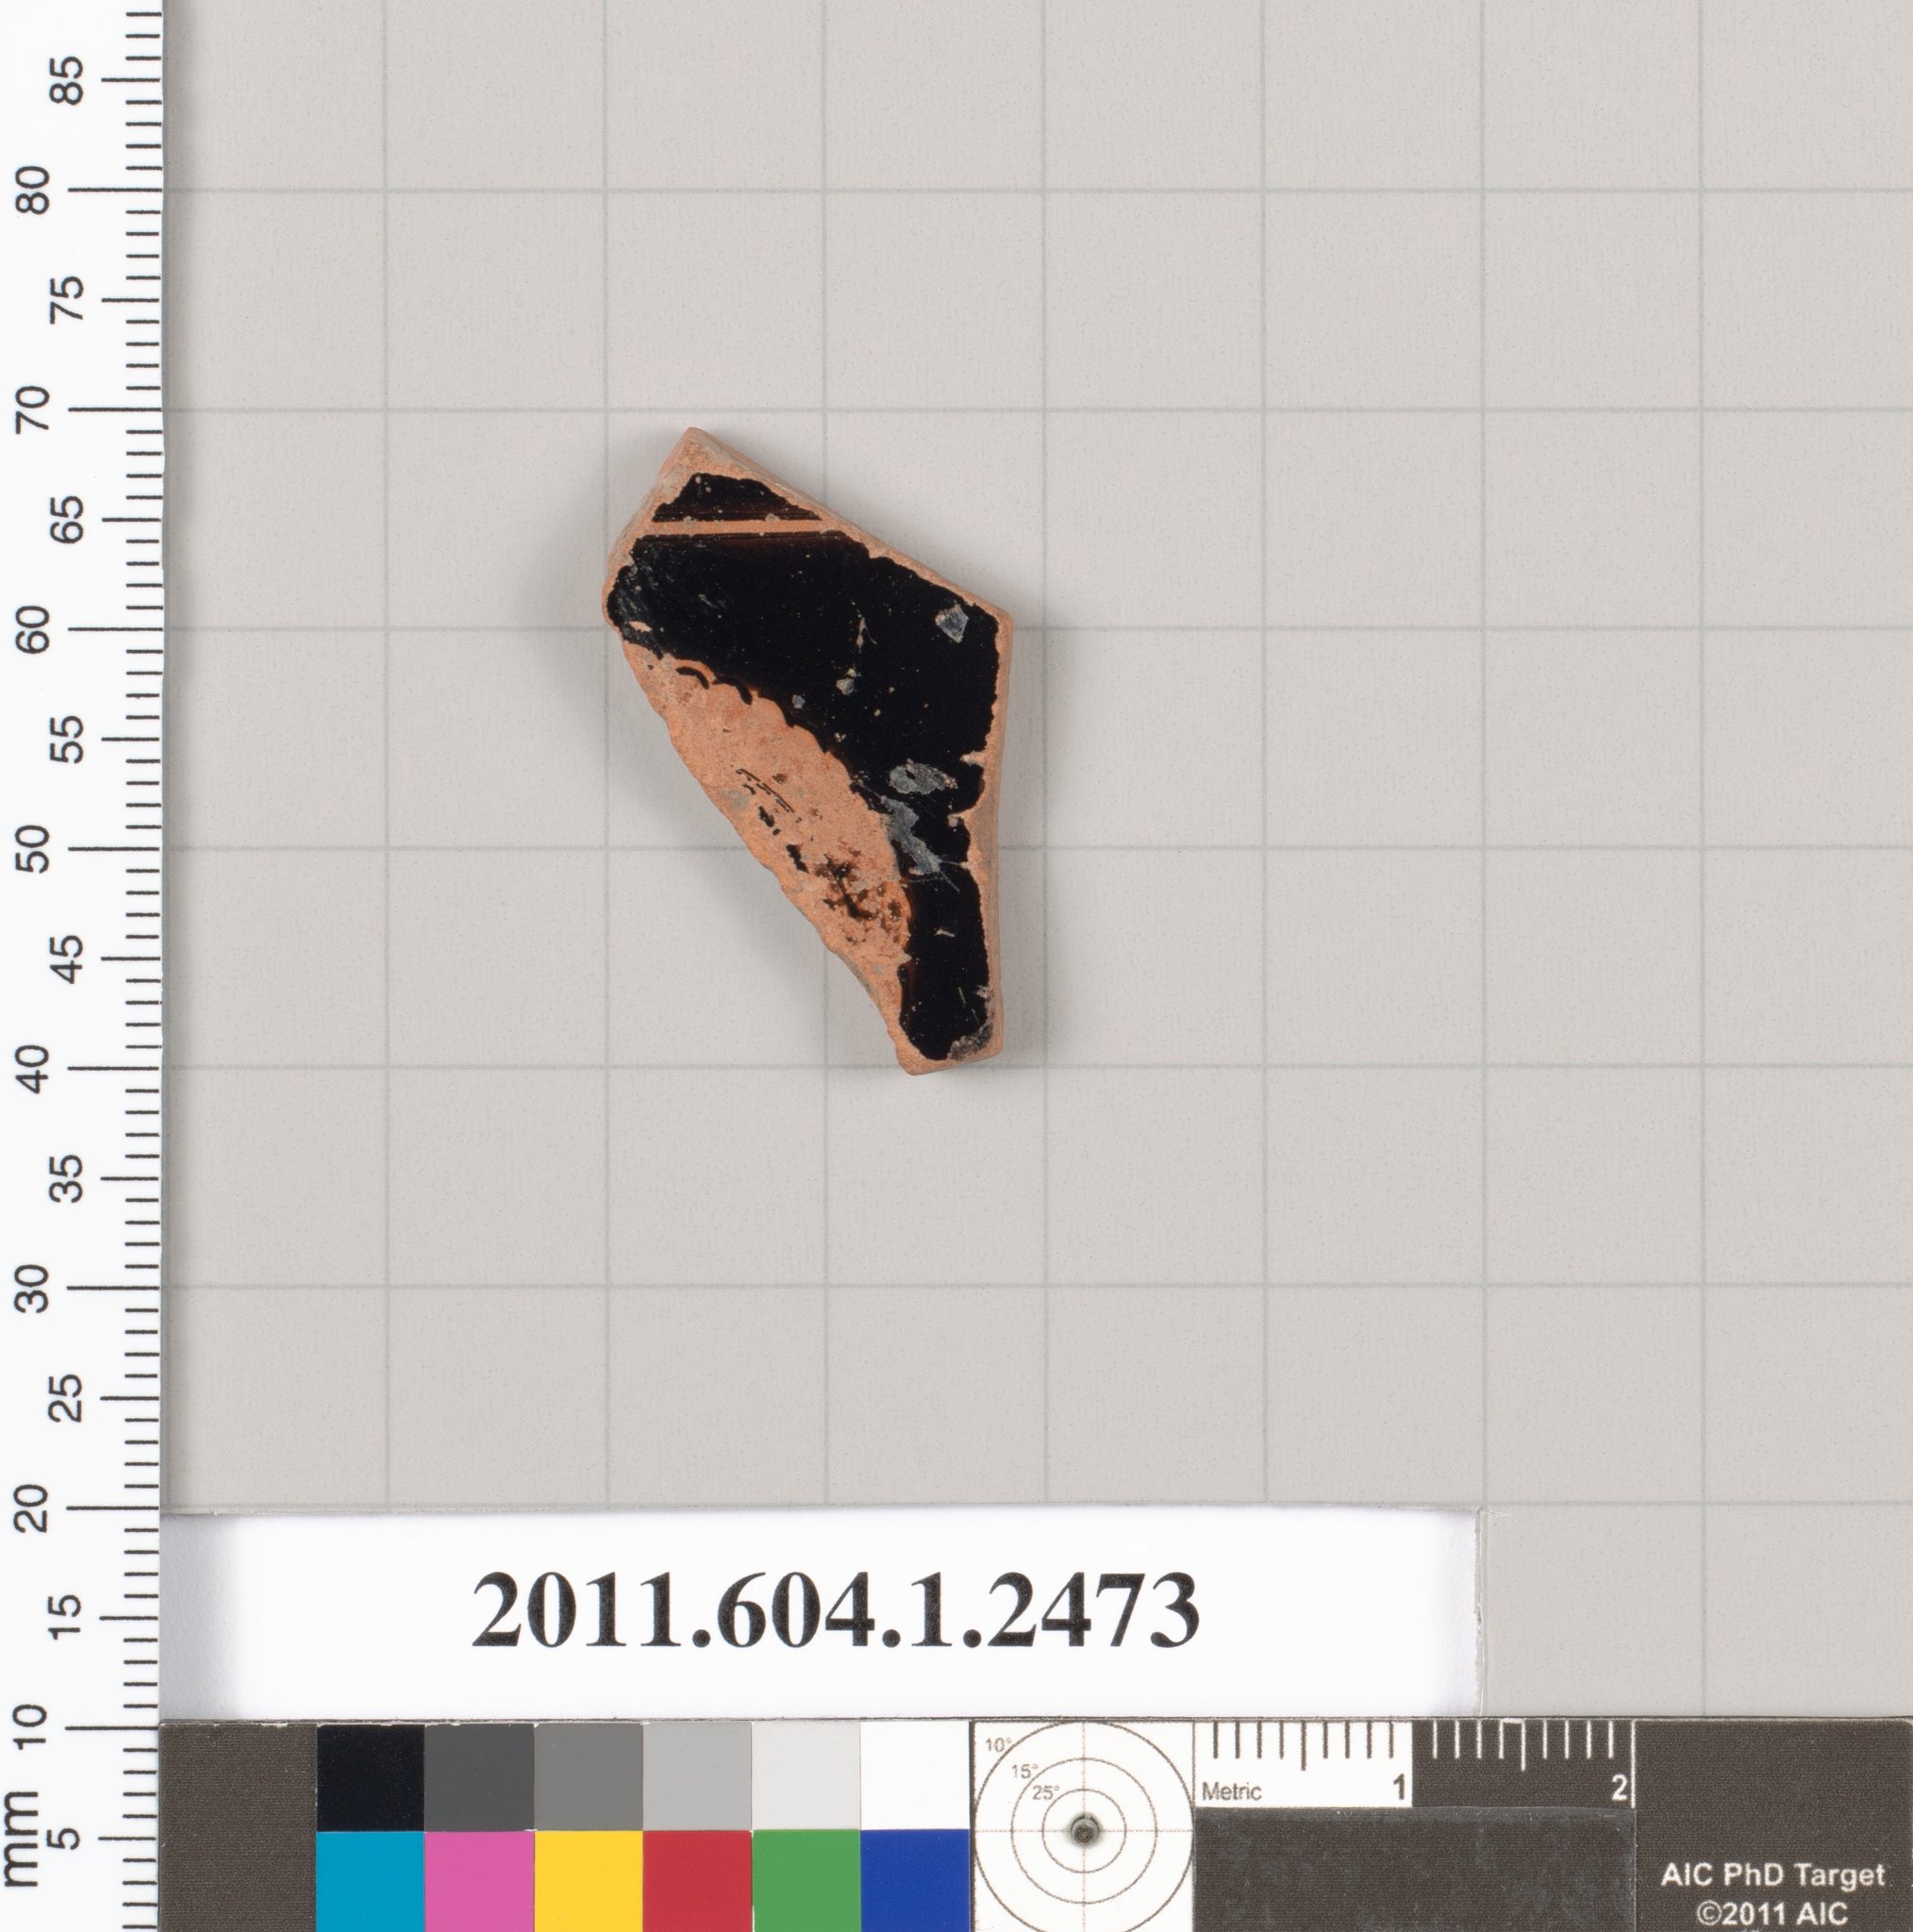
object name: kylix fragment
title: Terracotta fragment of a kylix (drinking cup)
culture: greek, attic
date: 500-476 BCE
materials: terracotta